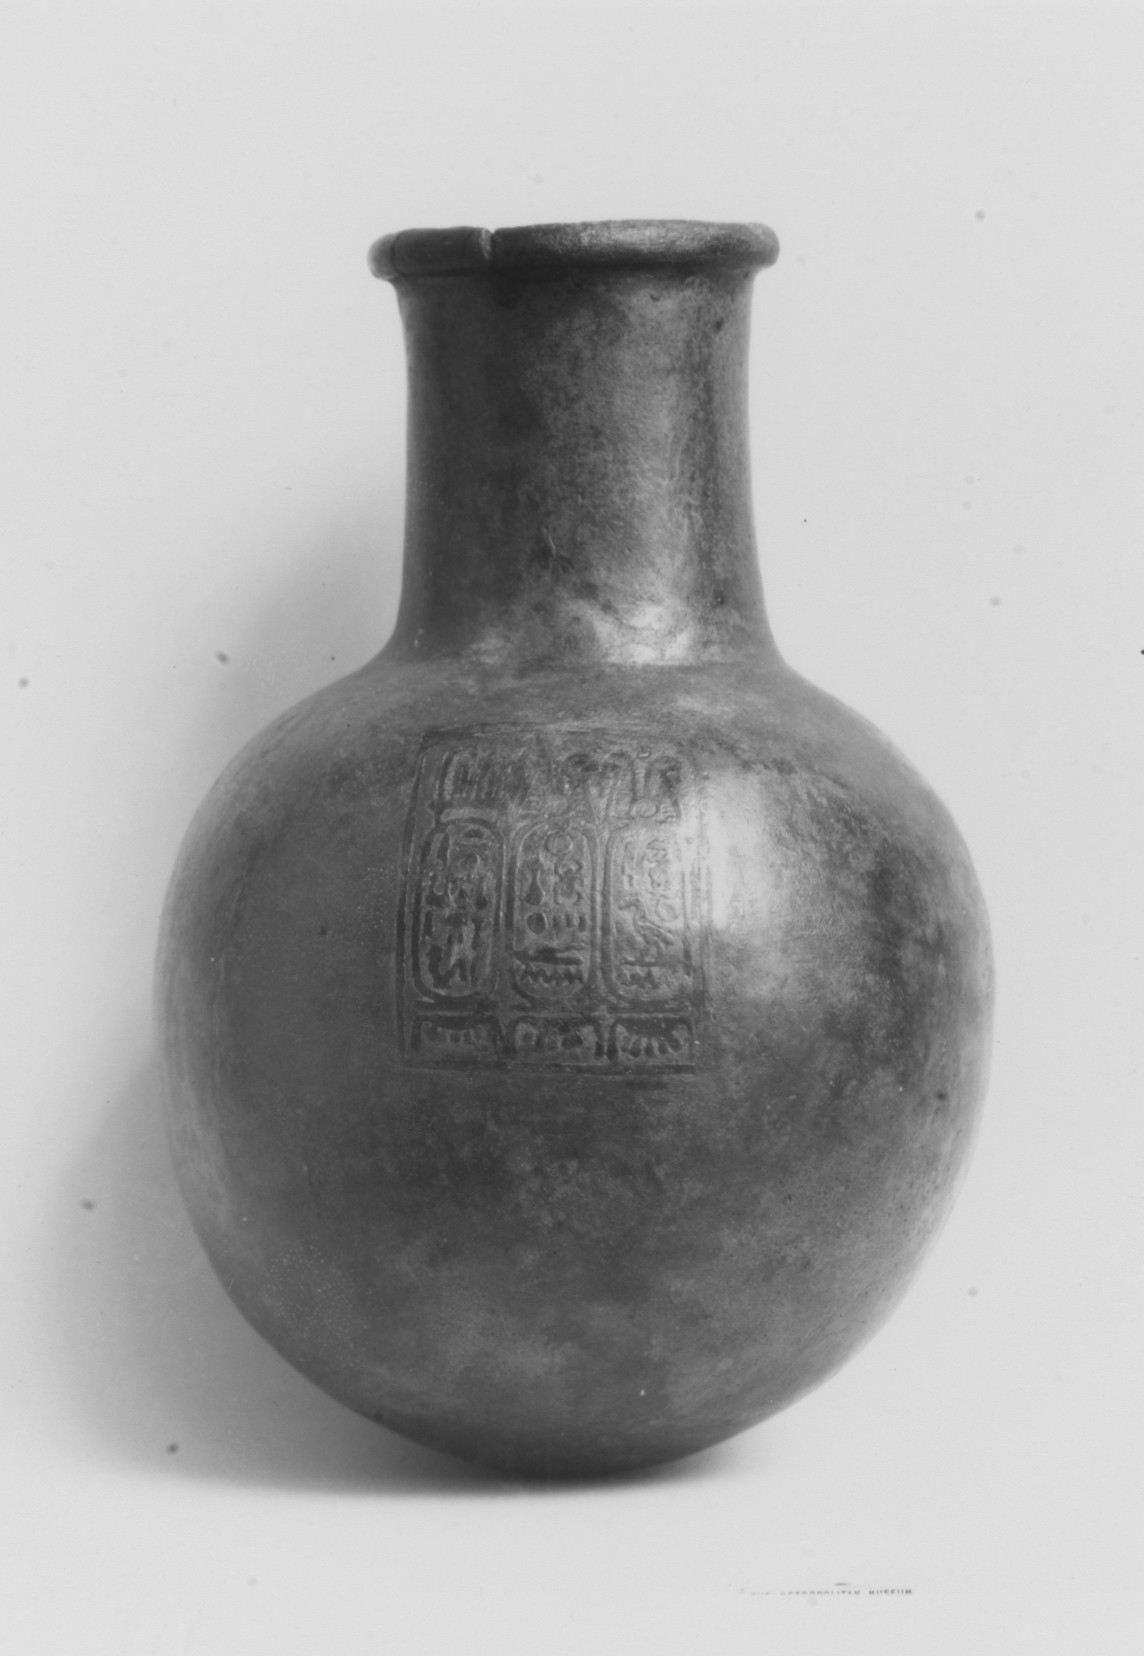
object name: bottle, akhenaten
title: Bottle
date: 1353-1336 BCE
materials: faience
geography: egypt